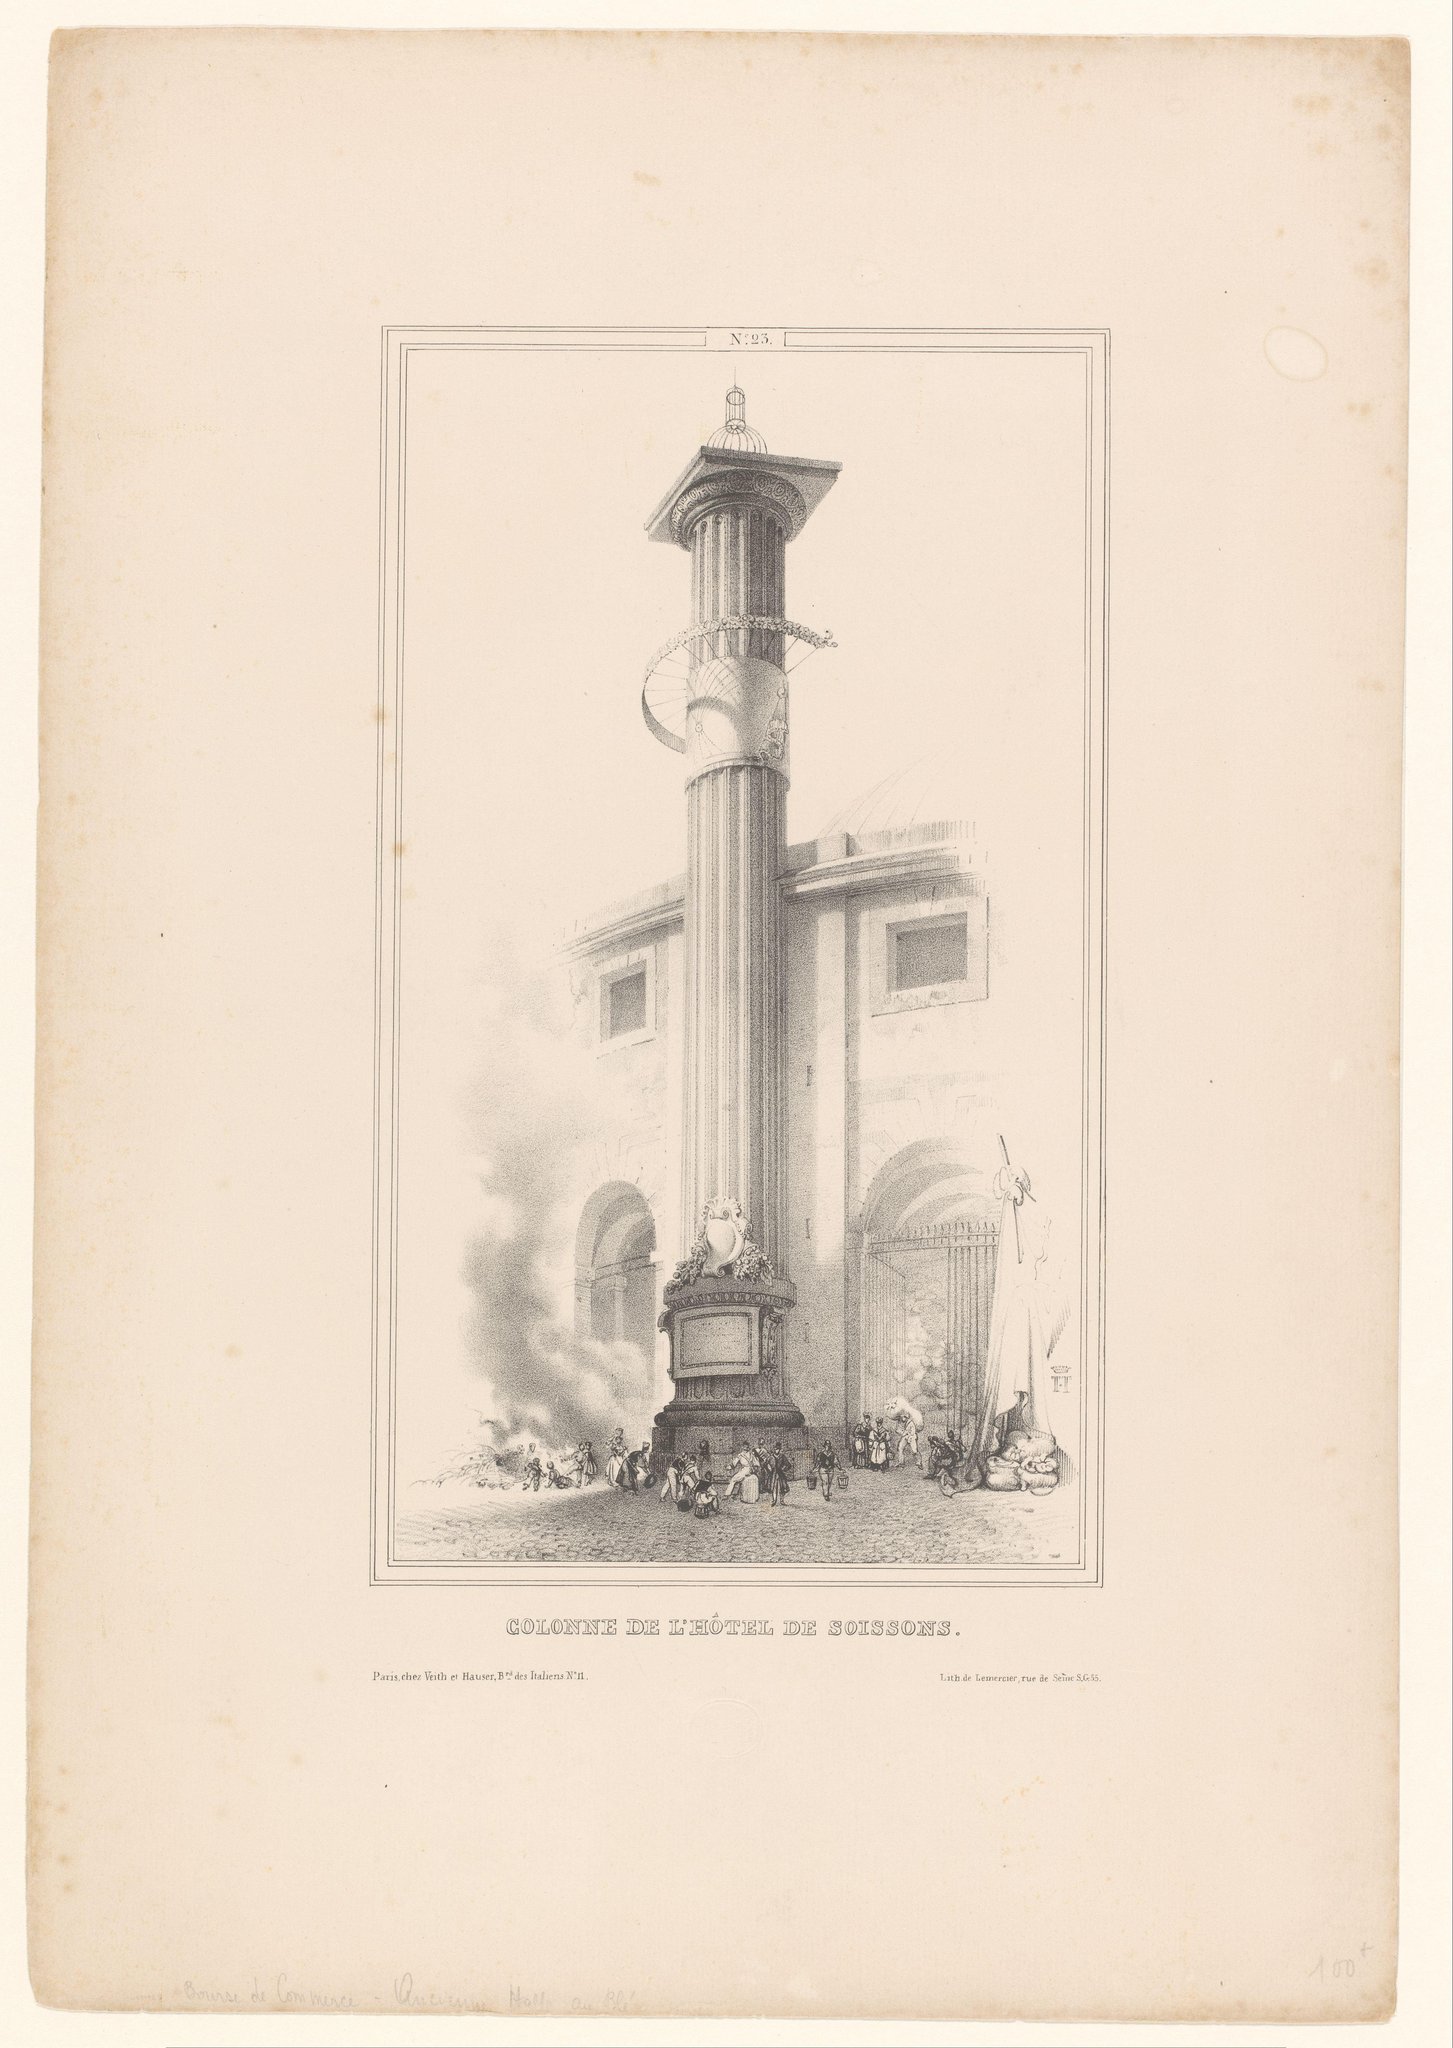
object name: print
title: Gezicht op de Colonne Médicis te Parijs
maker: Anonymous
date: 1828-1840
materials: paper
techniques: lithograph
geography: paris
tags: column, pillar ~ architecture, city-view, and landscape with man-made constructions (+ city(-scape) with figures, staffage)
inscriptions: check stamp: Lugt 4211